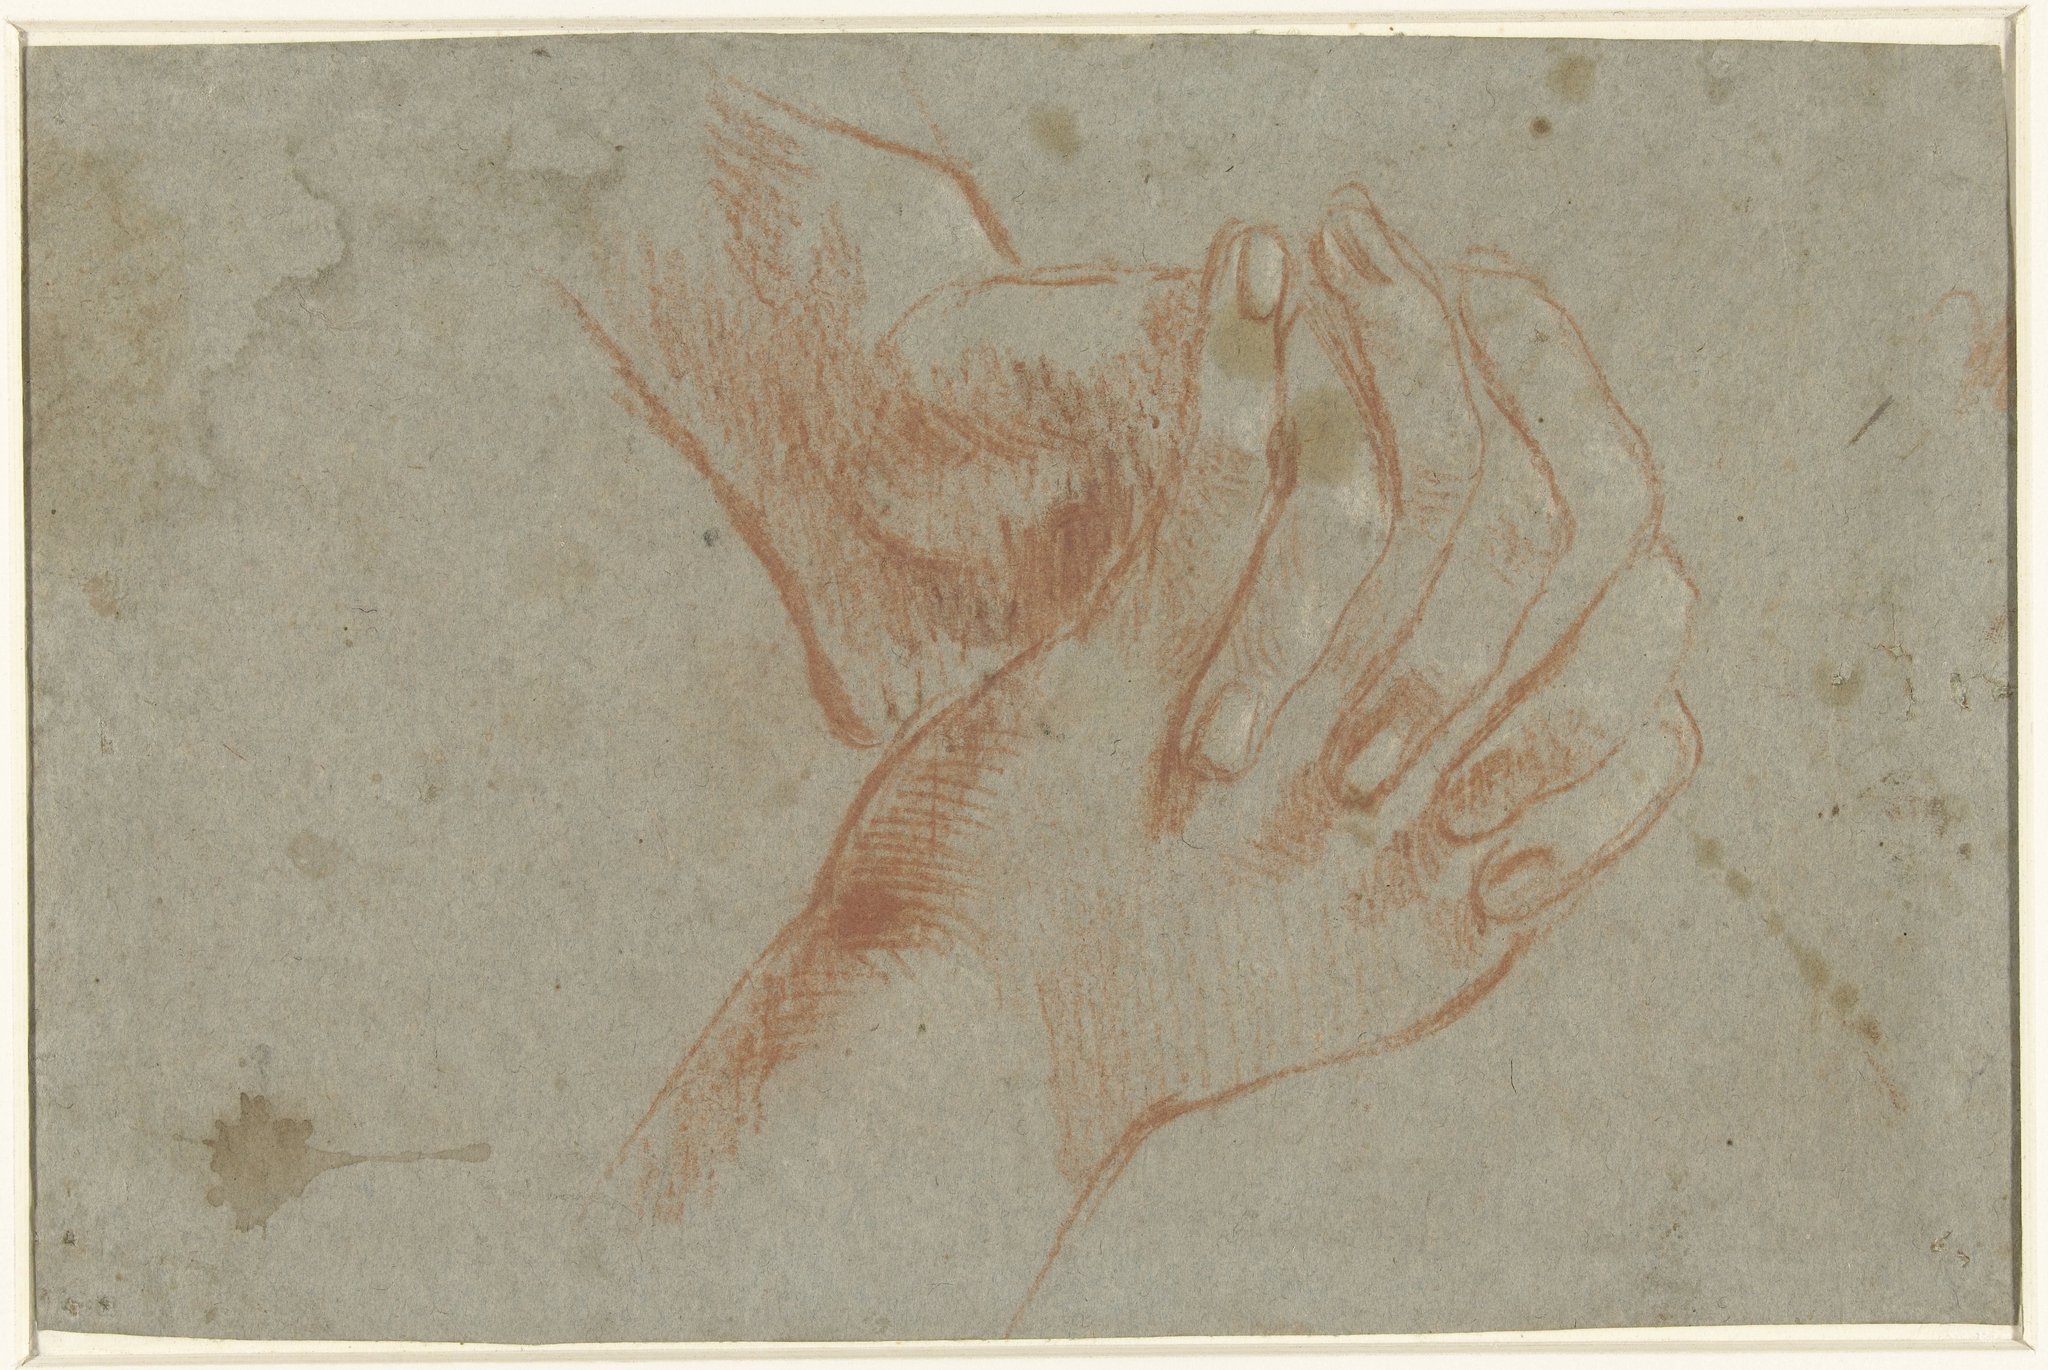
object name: drawing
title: Twee gevouwen handen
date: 1587-1660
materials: chalk, paper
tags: hand, hands folded with fingers knit